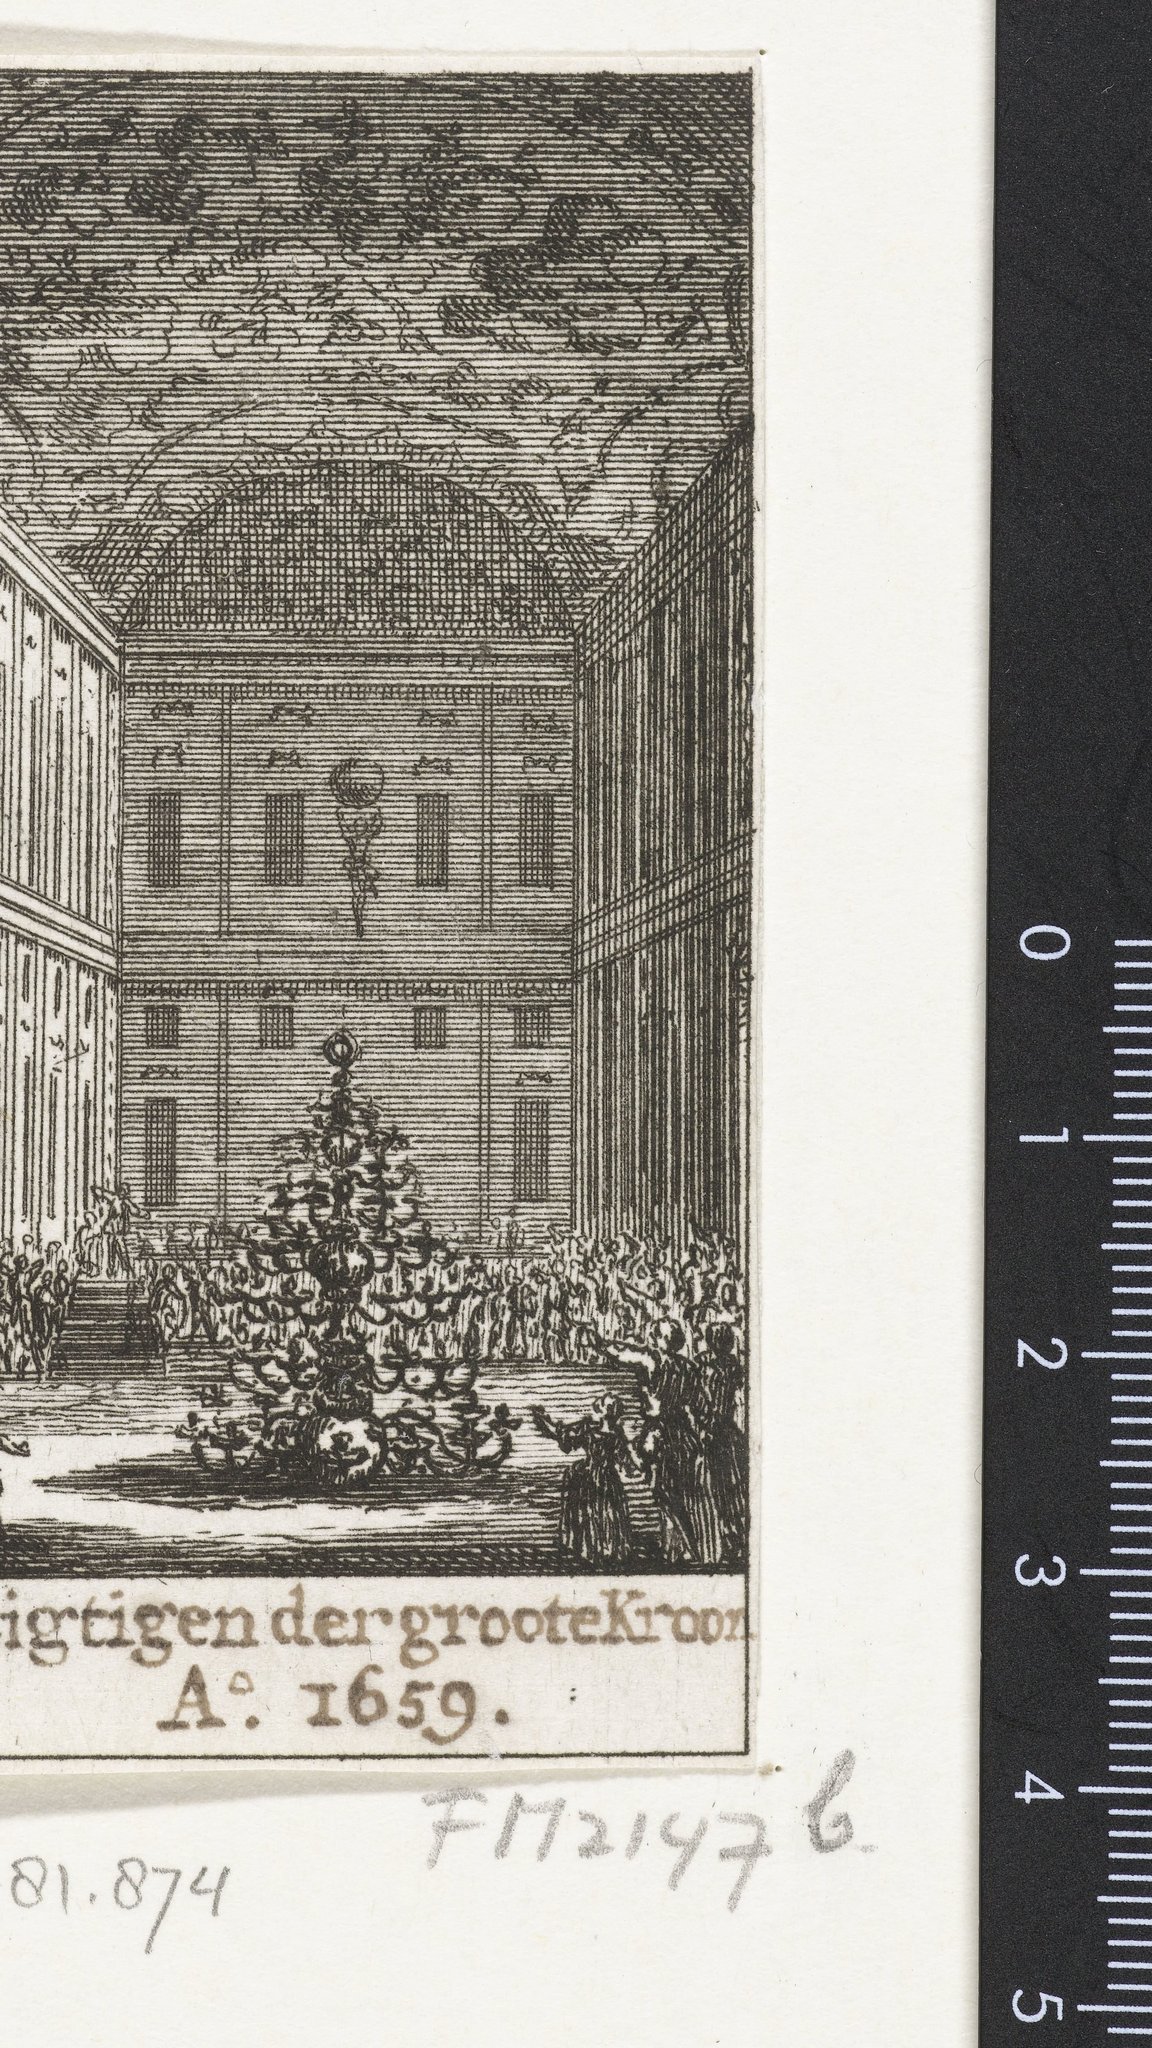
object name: print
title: Bezichtiging van de grote kroonluchter, geschenk aan de Russische tsaar, 1659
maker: simon fokke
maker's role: draughtsman, print maker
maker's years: 1712-1784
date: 1779-1781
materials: paper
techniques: etching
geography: netherlands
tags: chandelier, candelabrum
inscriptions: inscription: ‘Bezigtigen der groote Kroon. Ao. 1659’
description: Gebruikt als illustratie in: Jacobus Kok, Amsteldamsche jaarboeken, behelzende de merkwaardigste geschiedenissen, welken, zo binnen de stad als daaromtrent, zijn voorgevallen, sedert haare eerste beginselen, tot op den tegenwoordigen tijd ... / Bijeengebragt door Jacobus Kok, 3 dln., J.B. Elwe, Amsterdam 1781.